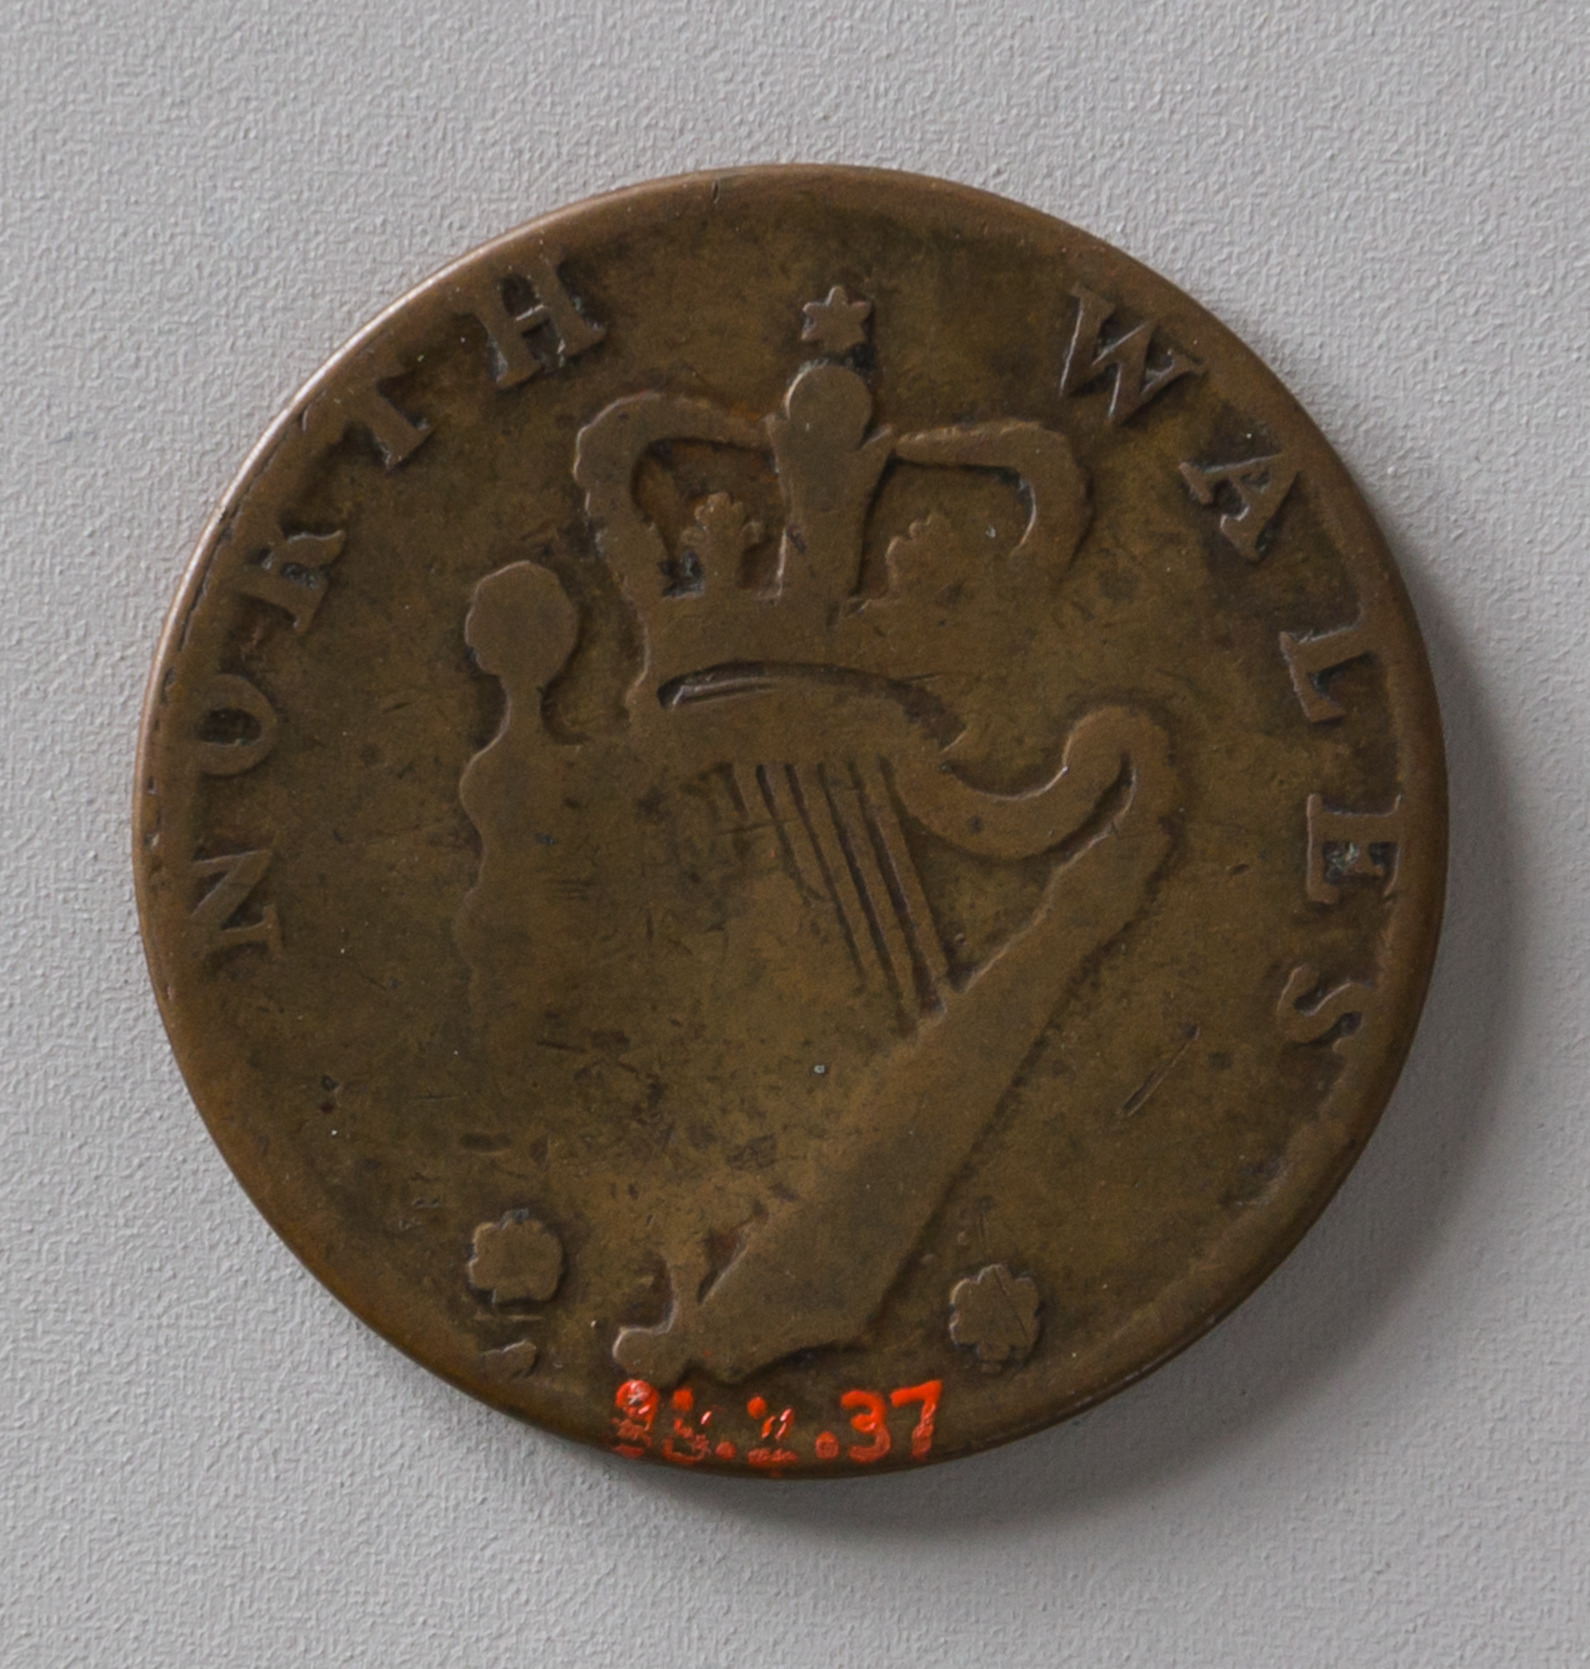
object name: medal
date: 1770-1800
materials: copper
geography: england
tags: george washington,profiles